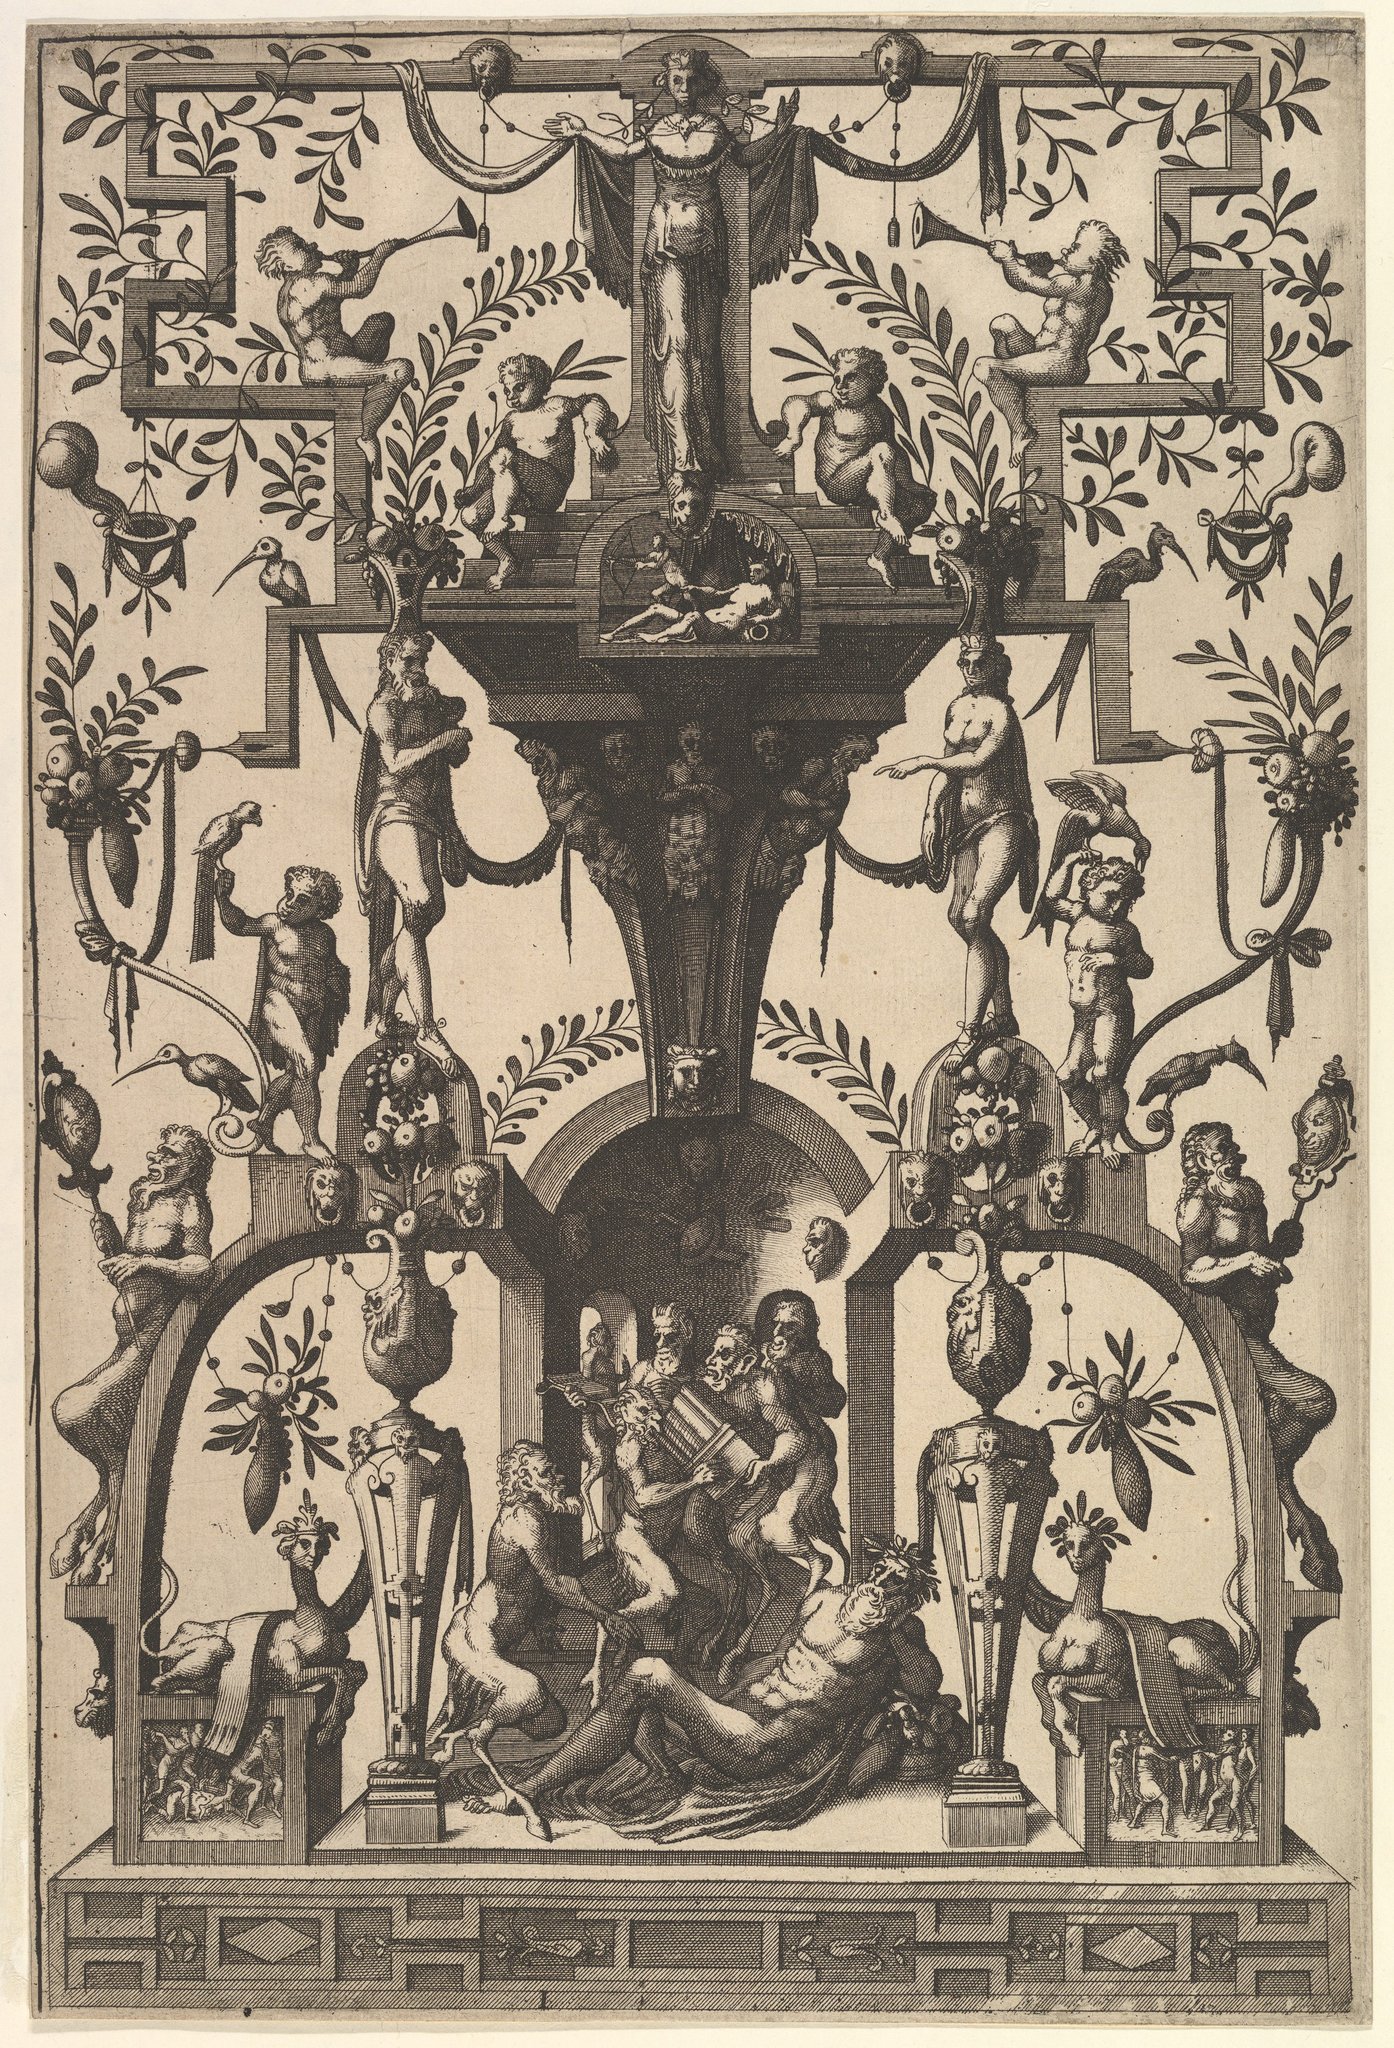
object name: book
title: Surface Decoration, Grotesque with Strapwork, Including a Wall Niche under a Strapwork Canopy, Bacchic Scene below from Veelderleij Veranderinghe van grotissen ende Compertimenten...Libro Primo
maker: johannes van doetecum i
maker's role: artist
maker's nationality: netherlandish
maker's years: 1528-1605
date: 1556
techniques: etching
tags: birds,grotesques,ornament,mythical creatures,satyrs